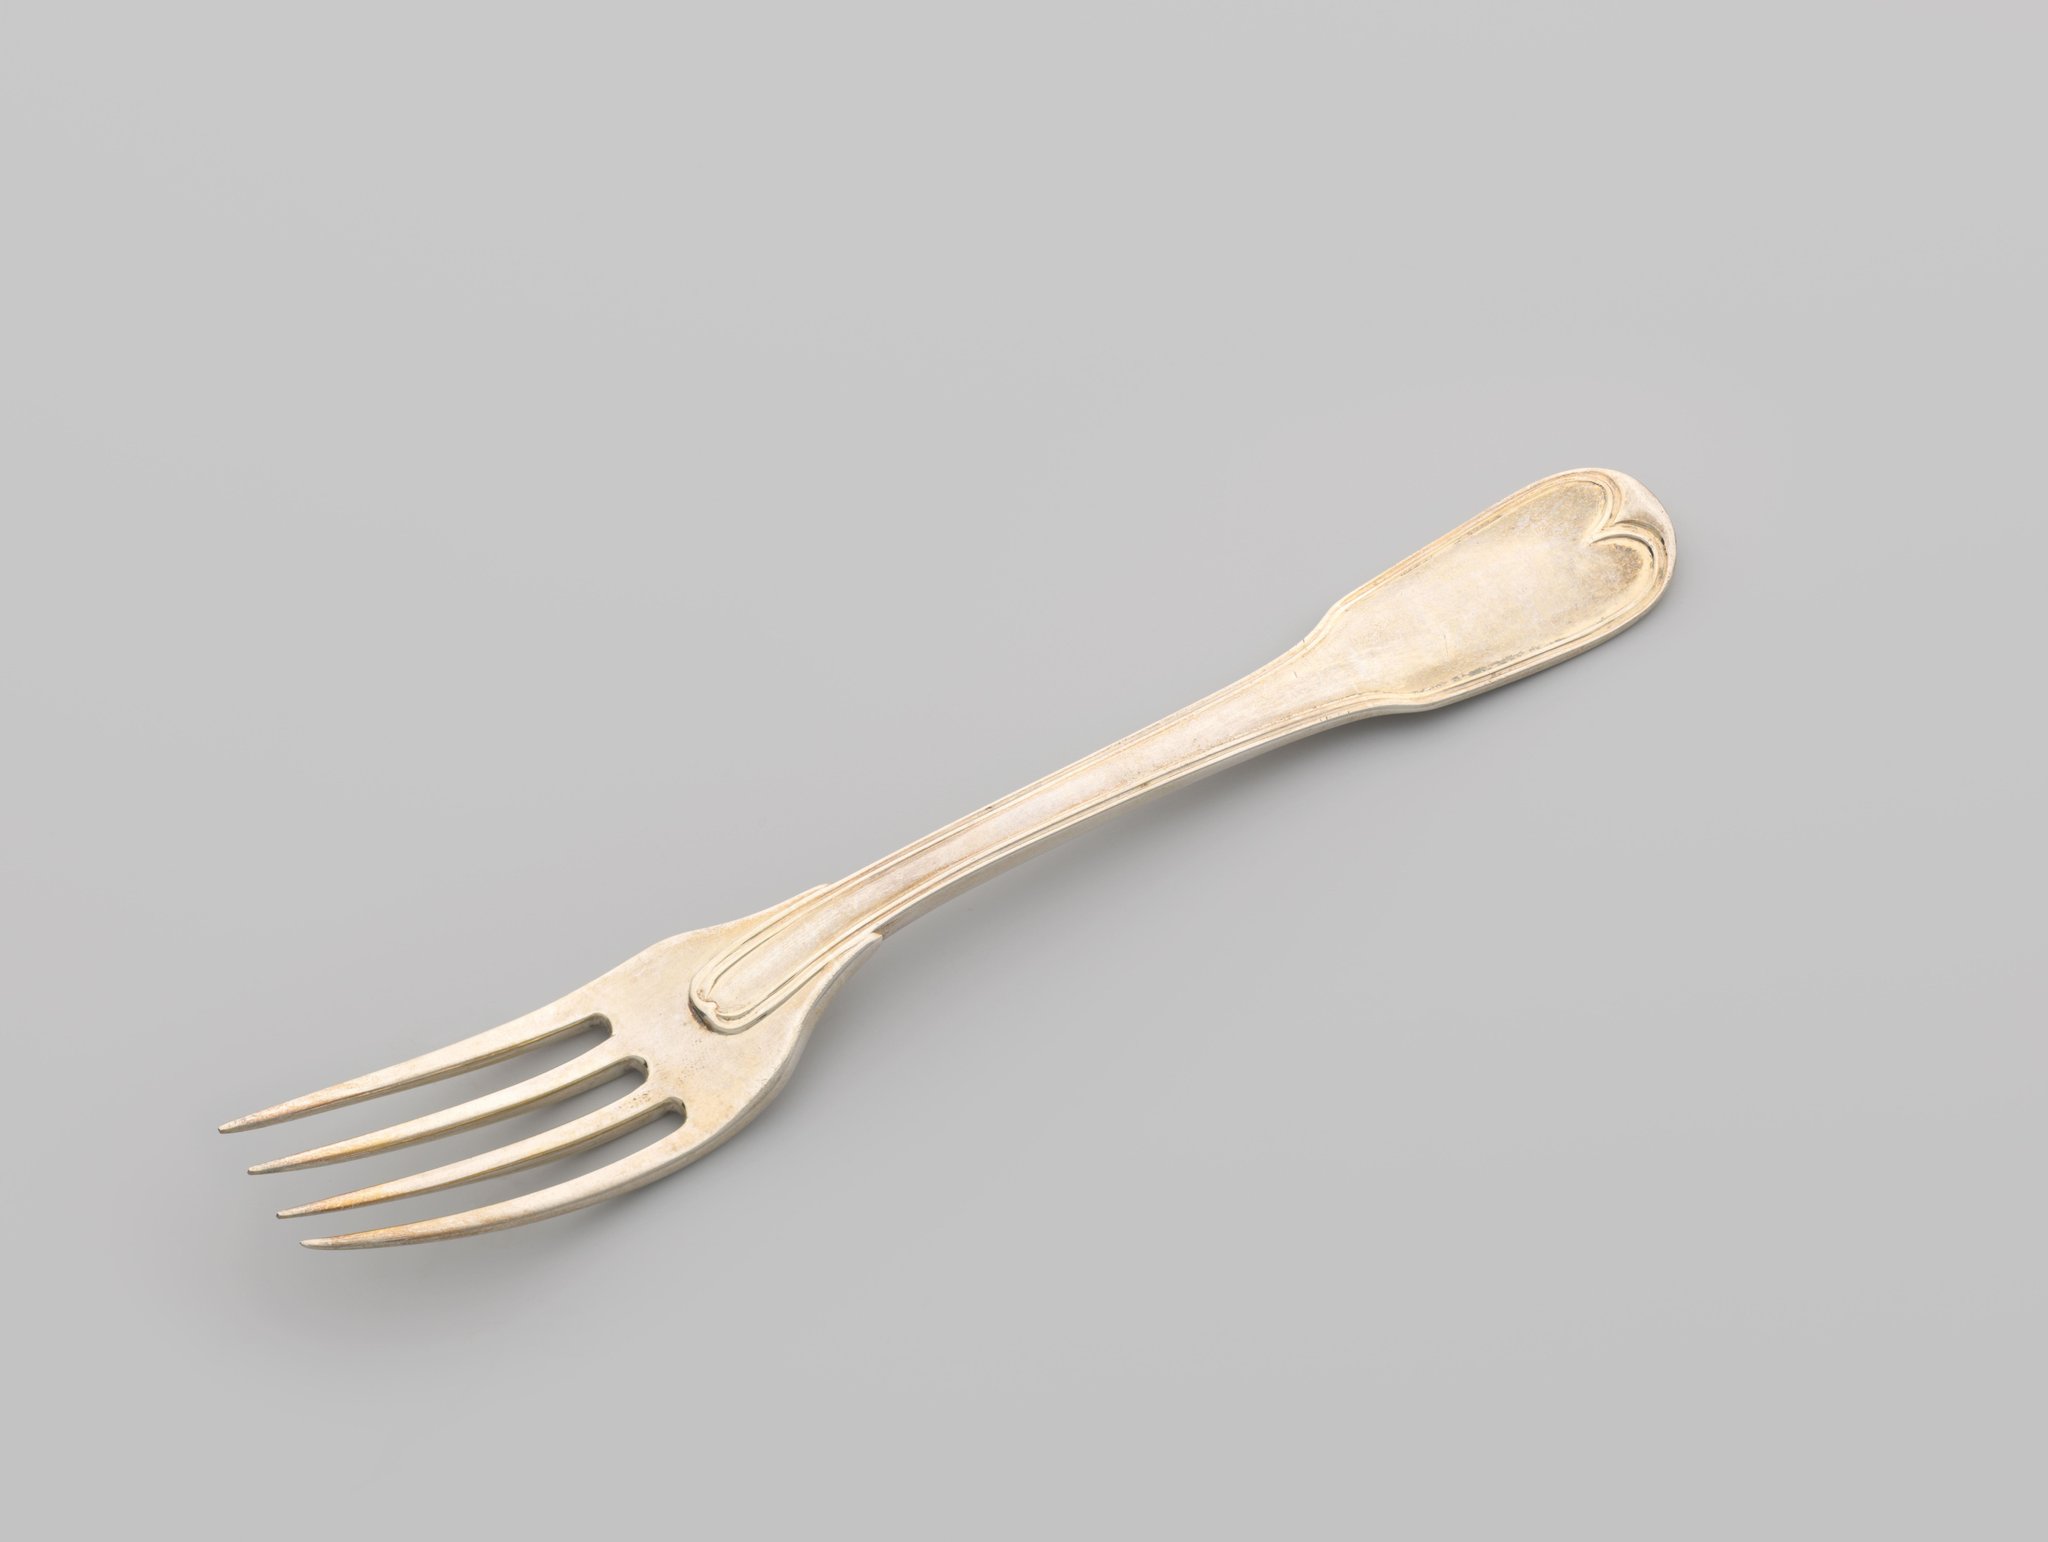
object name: fork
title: Dessertvork met het helmteken Clifford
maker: roelof helweg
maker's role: silversmith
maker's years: 1758-1843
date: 1806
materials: silver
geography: amsterdam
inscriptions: town mark: ‘Amsterdam’, date letter: ‘X (=1806)’, alloy mark: ‘Hollandse leeuw’, maker's mark: ‘RH in ovaal’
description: De viertandige vork is aan zowel boven- als onderzijde door middel van enkel lof verbonden met de platte, gebogen steel, die zich verbreedt naar het spatelvormige uiteinde. Boven- en onderzijde van de steel worden omgeven door een dubbele filetrand, die bij het uiteinde ingezwenkt is. Op de onderzijde van de spatel is het helmteken Clifford gegraveerd.